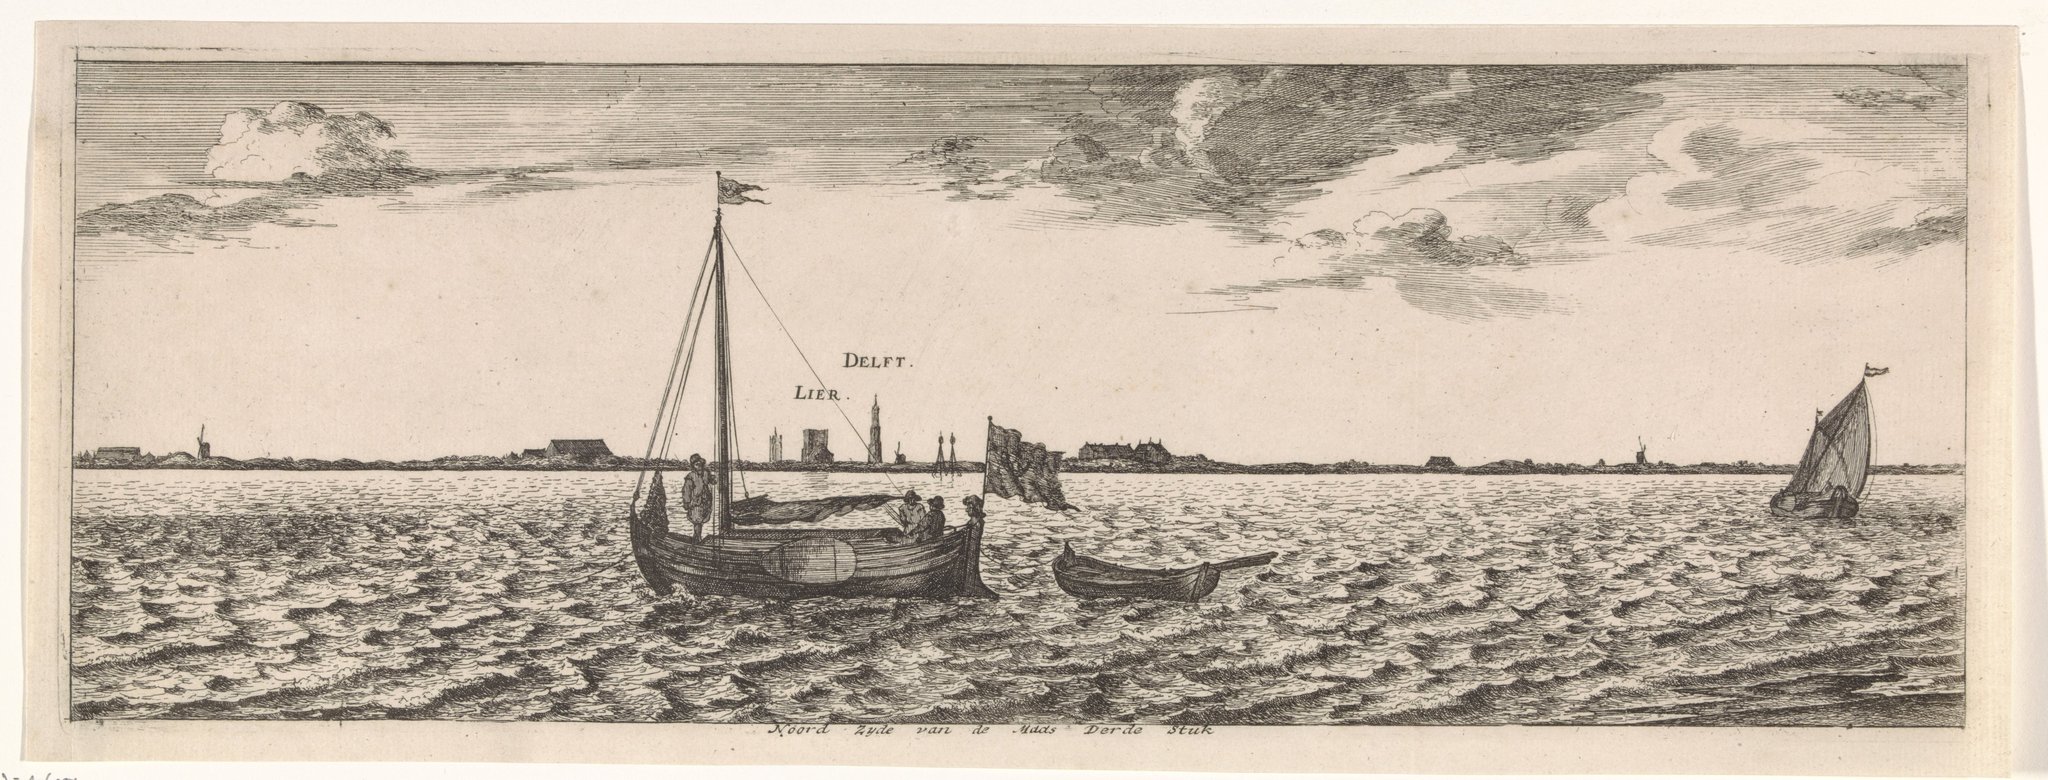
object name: print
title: Postkaart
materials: paper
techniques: engraving, etching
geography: rotterdam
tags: city-view in general; 'veduta', river, delft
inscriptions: collector's mark: Lugt 2228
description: Gezicht op de noordzijde van de Maas met op de achtergrond Delft en De Lier.